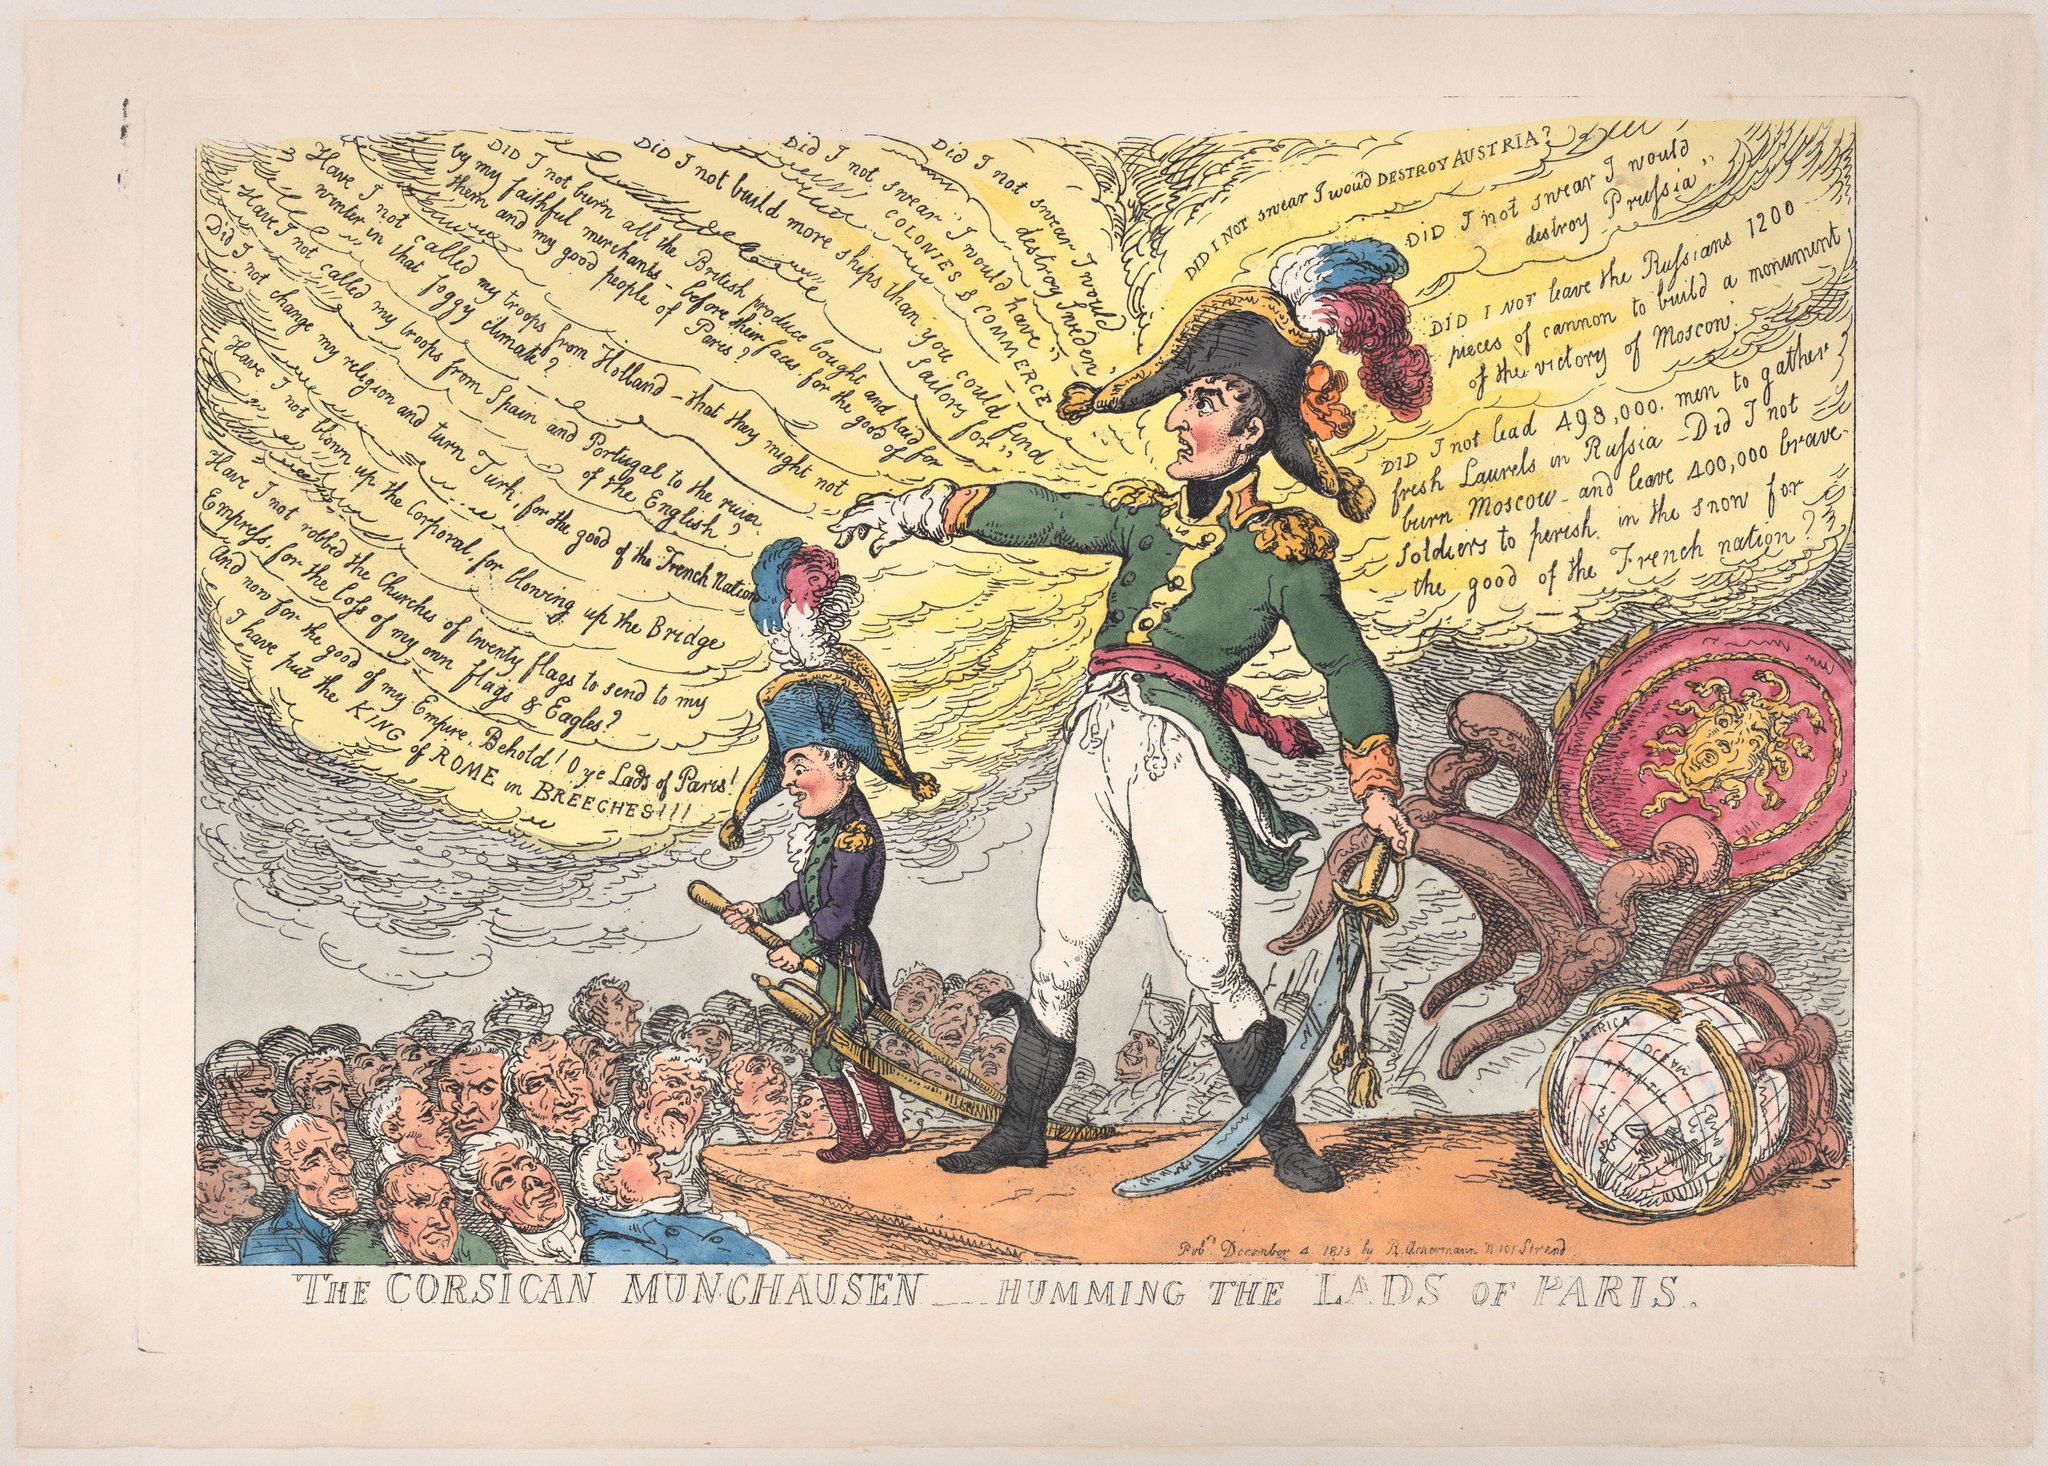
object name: print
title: The Corsican Munchausen – Humming the Lads of Paris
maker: thomas rowlandson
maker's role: artist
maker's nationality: british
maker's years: 1757-1827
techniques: etching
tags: satire,napoleon i,politics